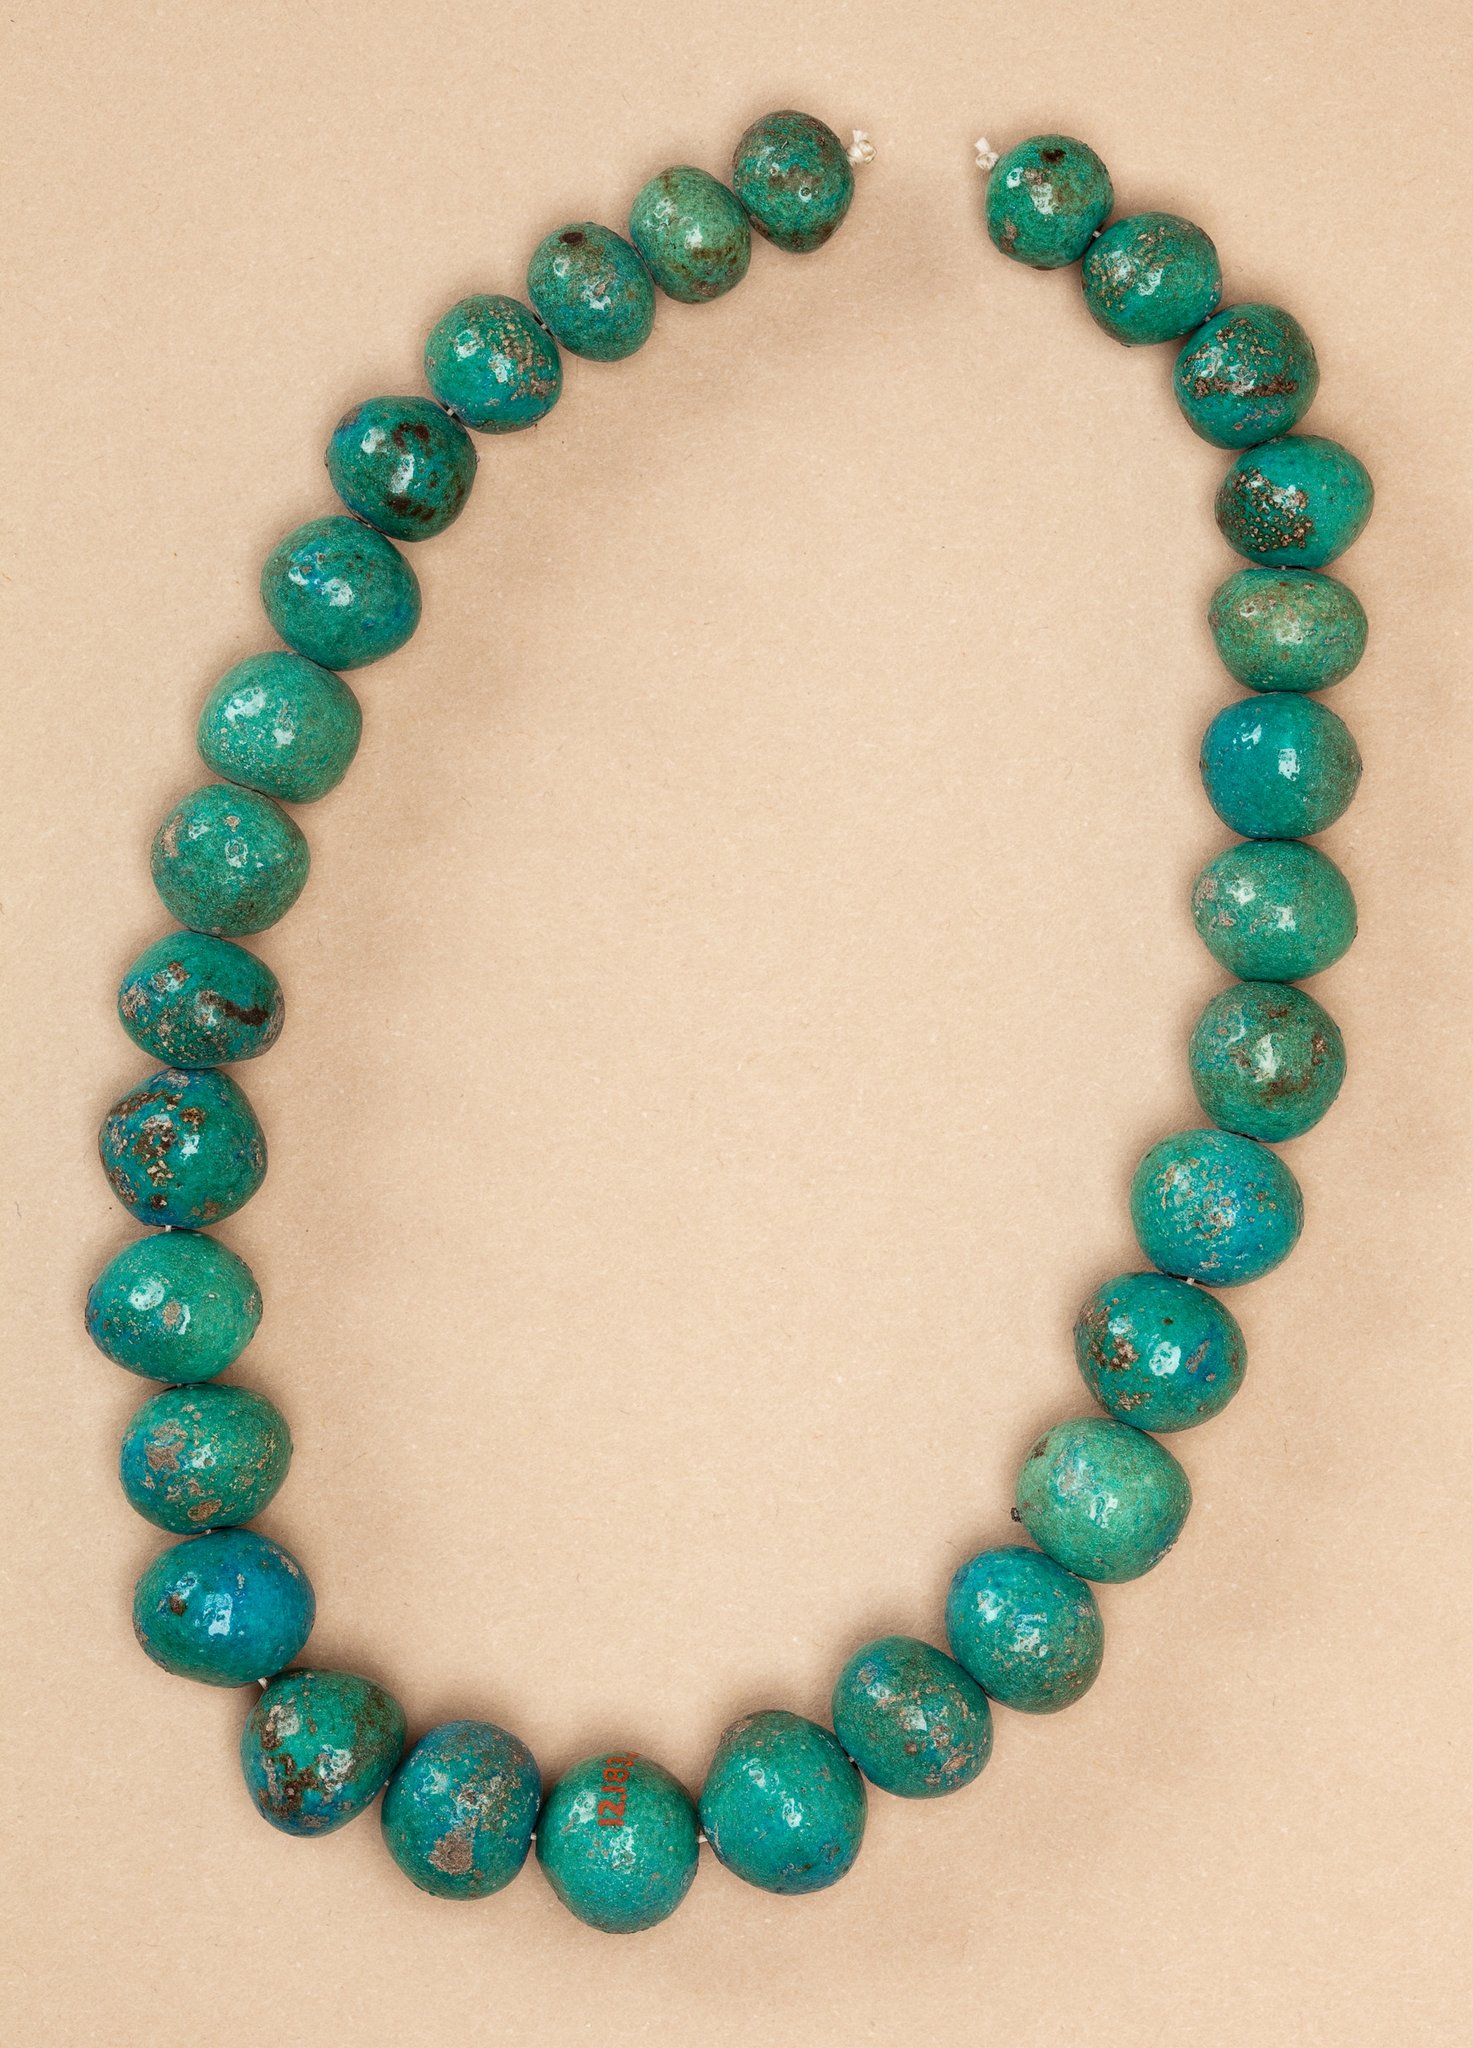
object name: bead, string, hapiankhtifi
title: String of beads of Hapiankhtifi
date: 1981-1802 BCE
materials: faience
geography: egypt